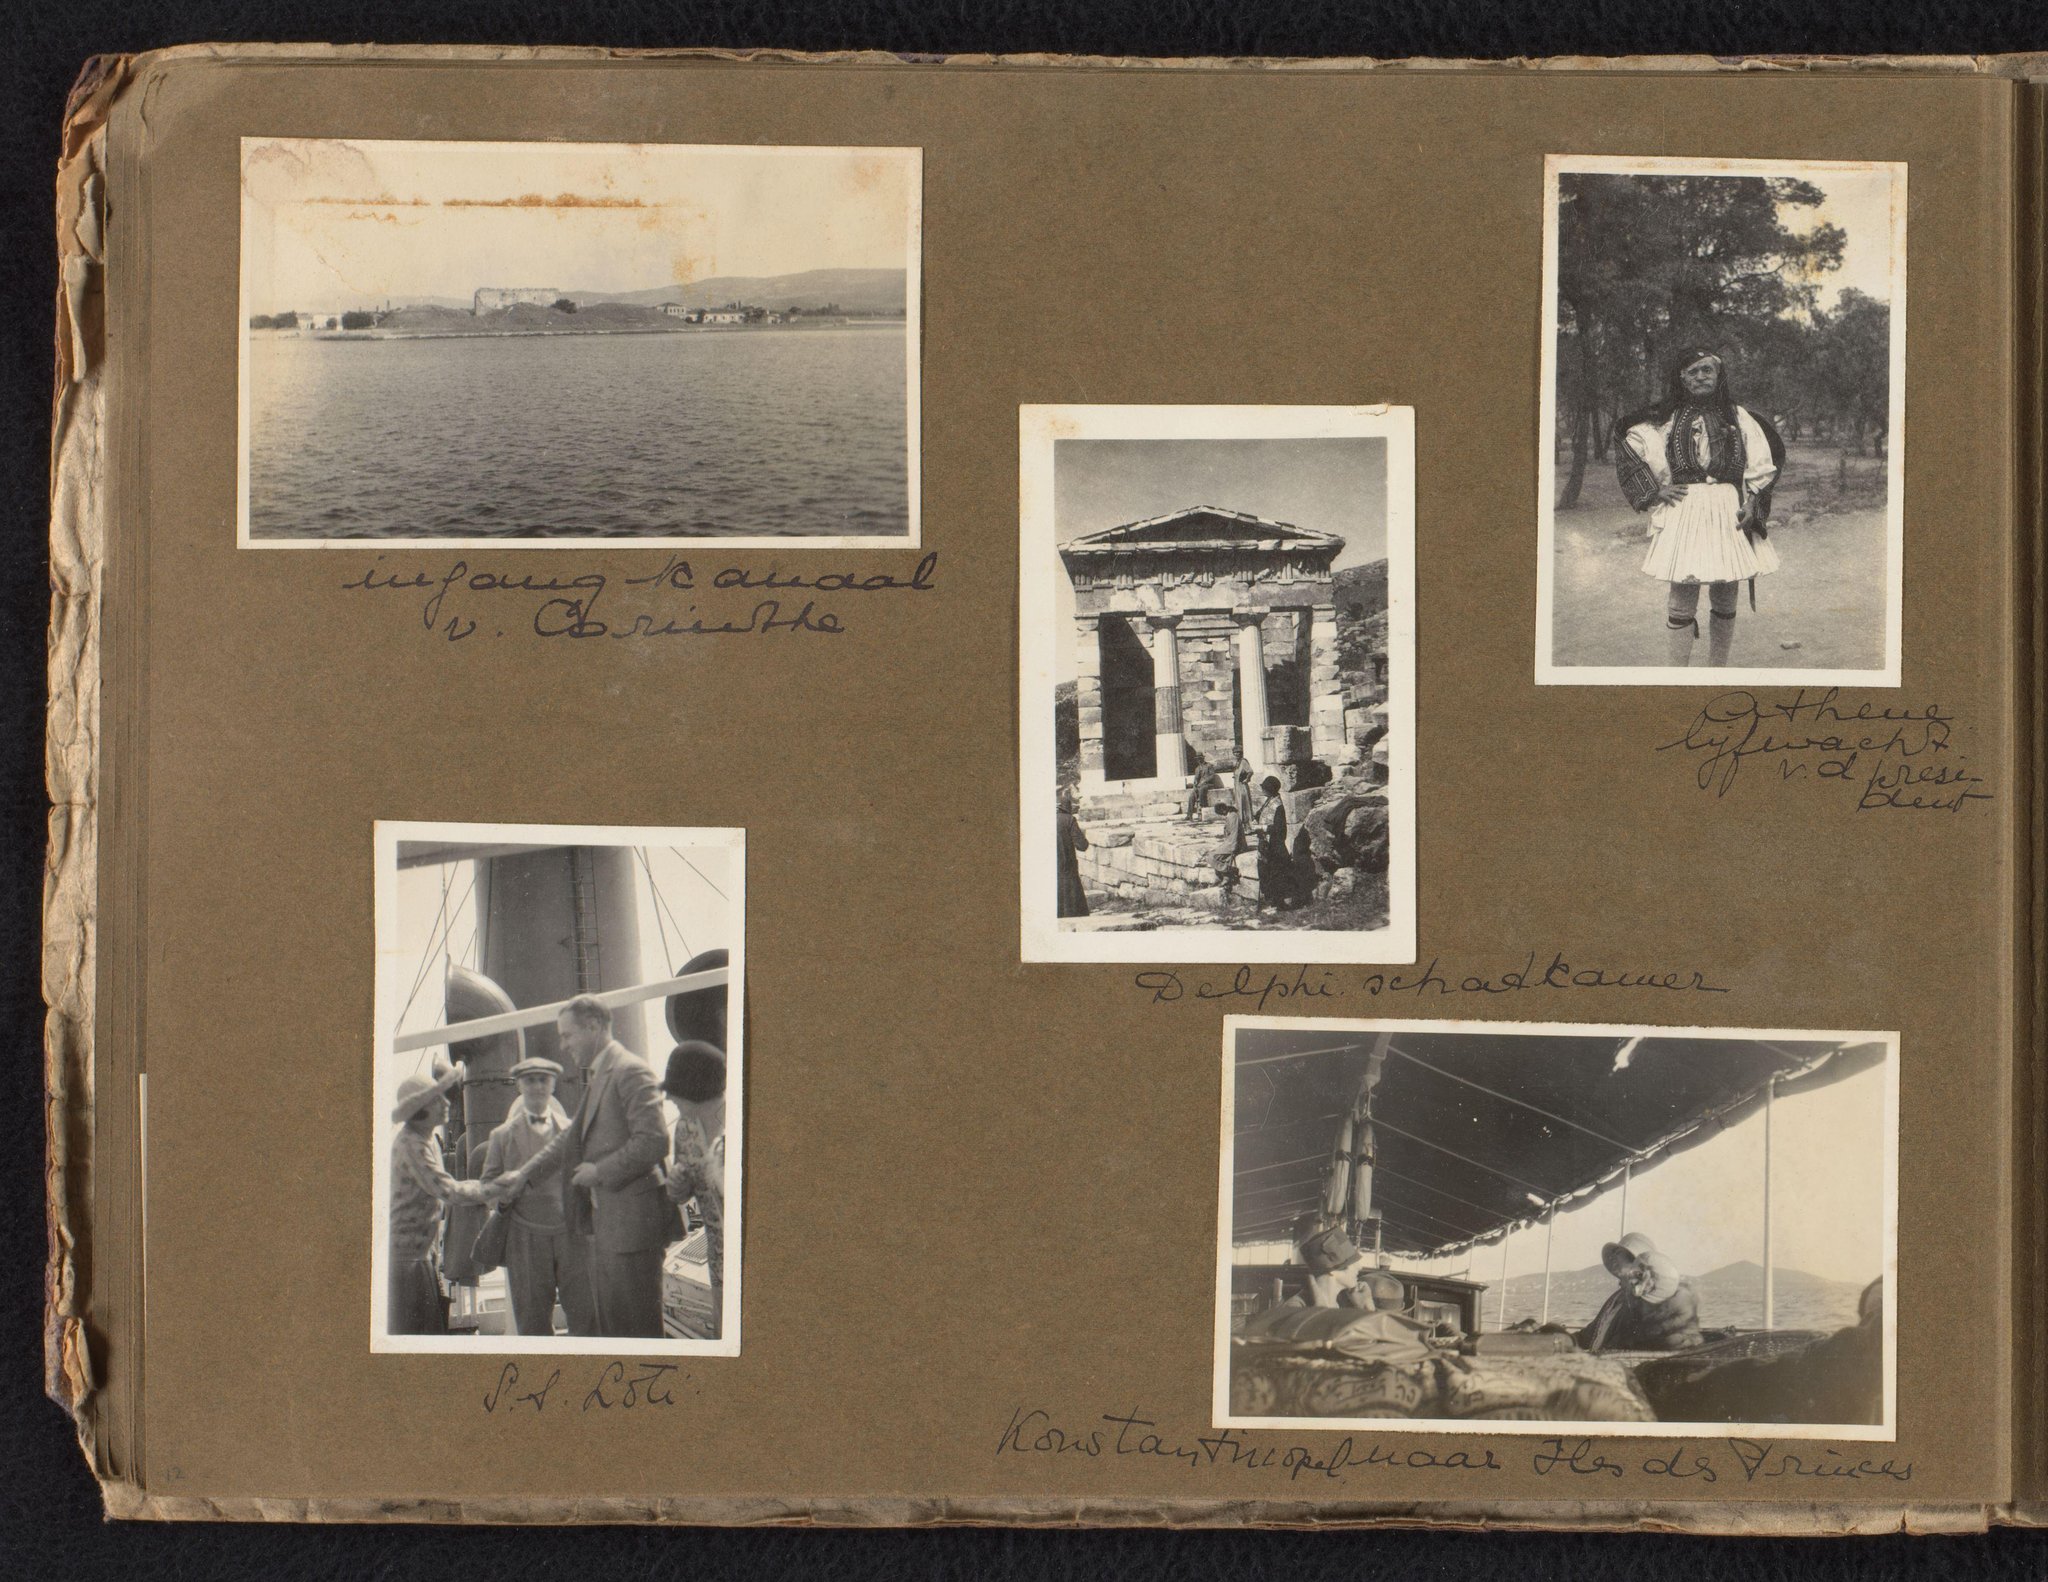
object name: album leaf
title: Vijf foto's van een reis naar Griekenland en Istanboel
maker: carolina frederika onnen (lien/loen)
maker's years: 1896-1983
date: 1909-1926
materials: paper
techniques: gelatin silver print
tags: canal, temple, shrine ~ greek religion, steamship, motorship, historical persons not known by name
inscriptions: inscription: ‘ingang kanaal/ v. Corinthe’, inscription: ‘Delphi schatkamer’, inscription: ‘Konstantinopel naar Iles des Princes’, inscription: ‘Athene/ lijfwacht/ v presi-/ dent’, inscription: ‘S.S. Loti’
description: Deze foto's maken deel uit van een album.